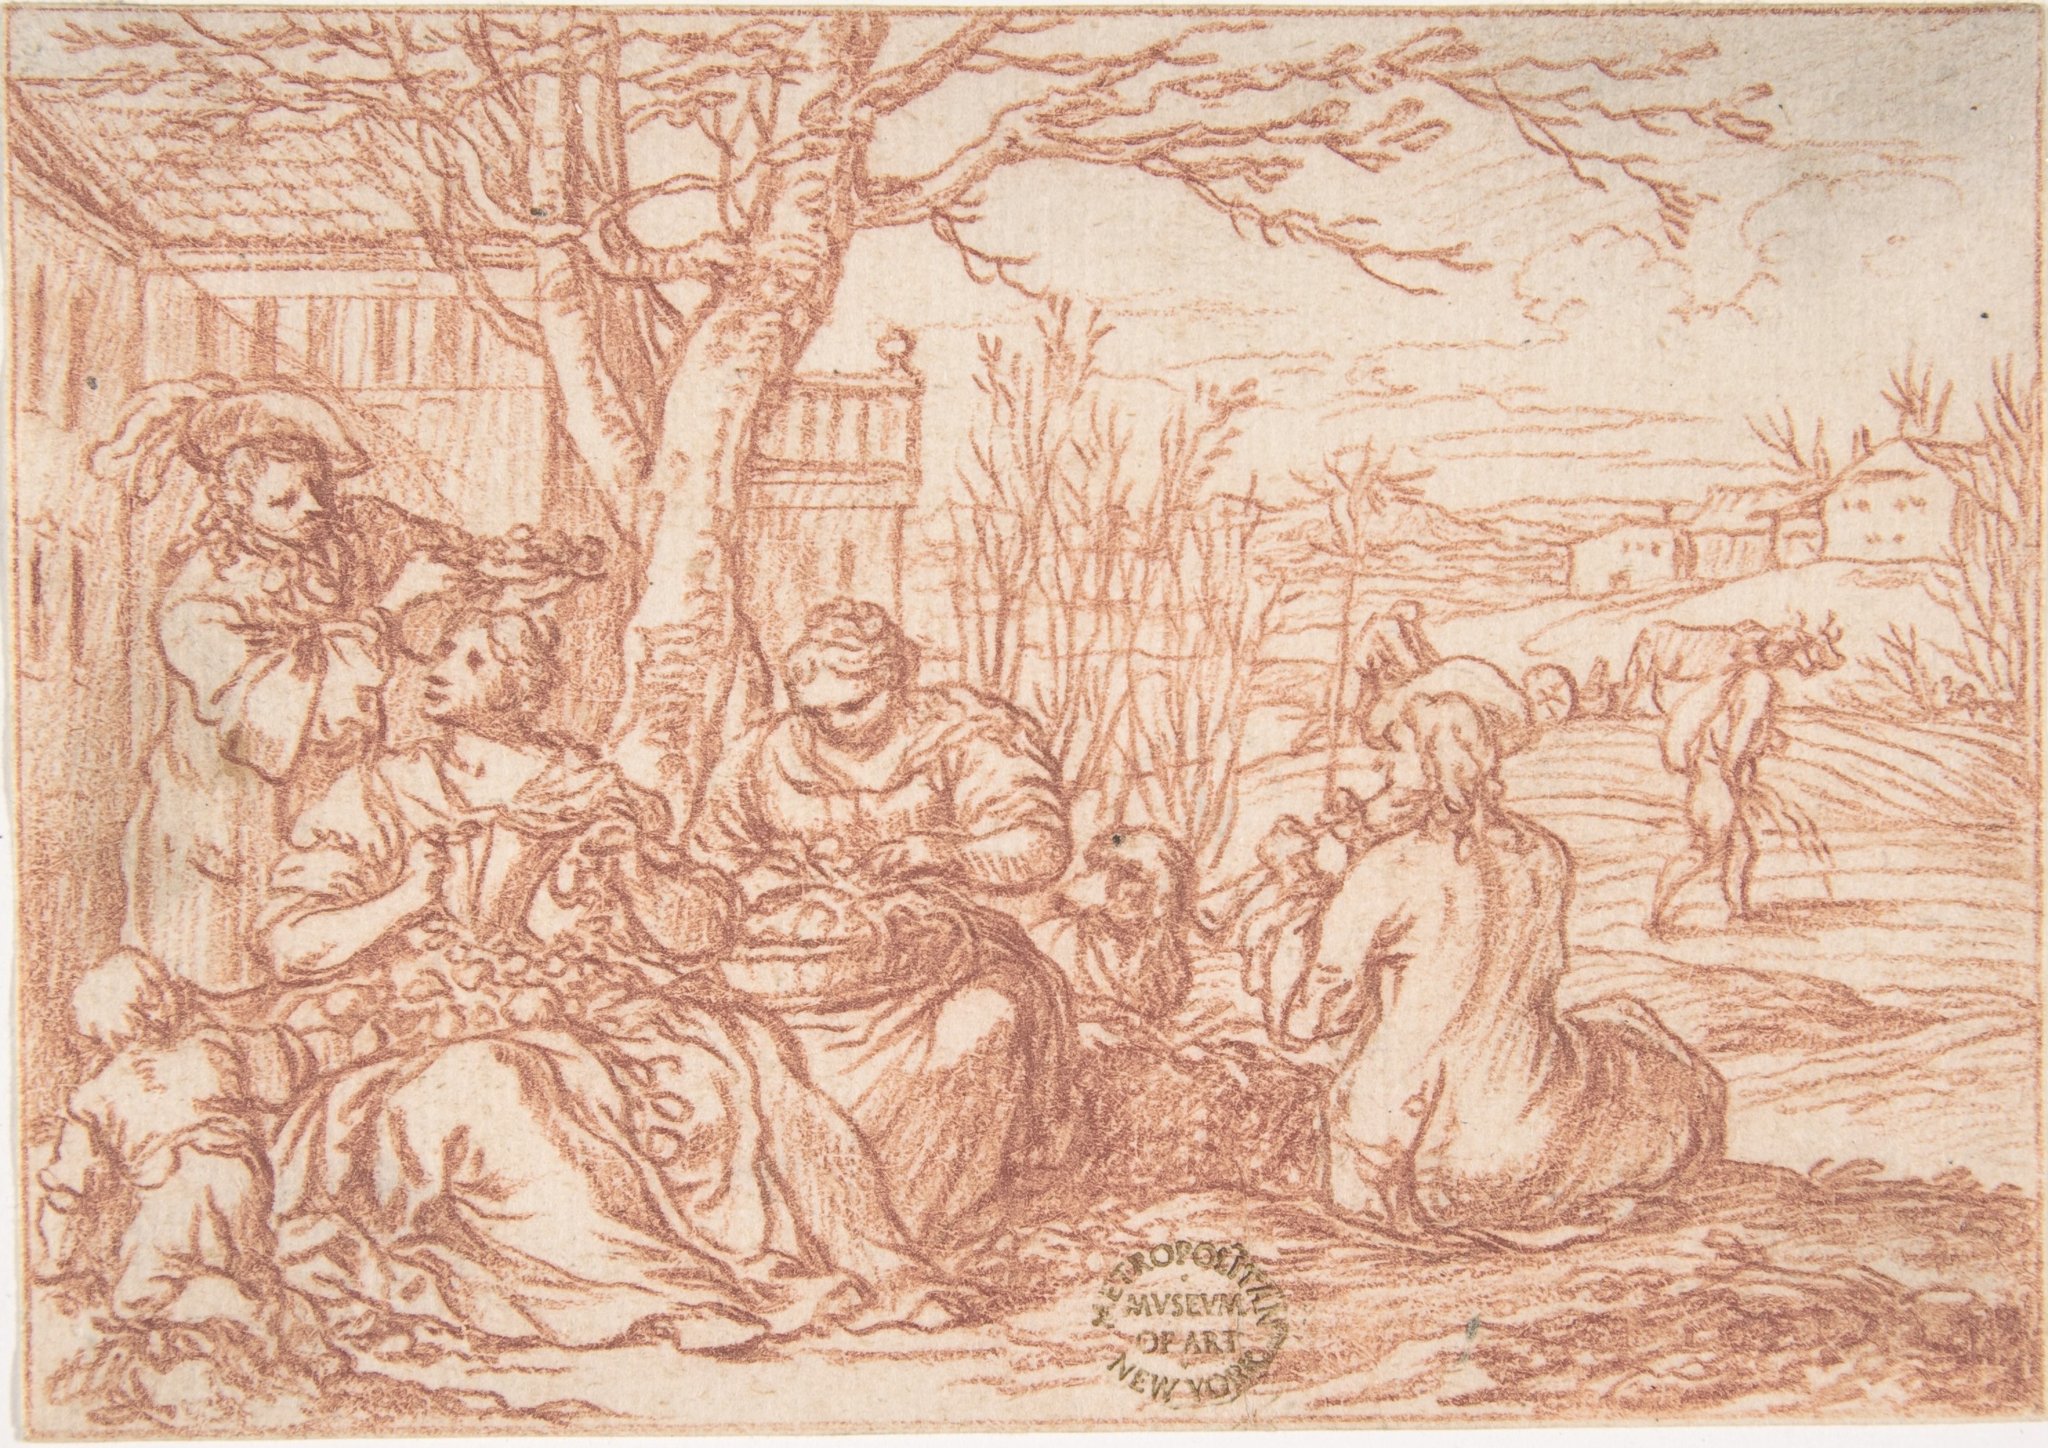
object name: drawing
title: April (one of a series representing the labors of the months)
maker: jonas umbach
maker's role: artist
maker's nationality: german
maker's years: 1624-1693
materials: chalk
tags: animals,buildings,women,trees